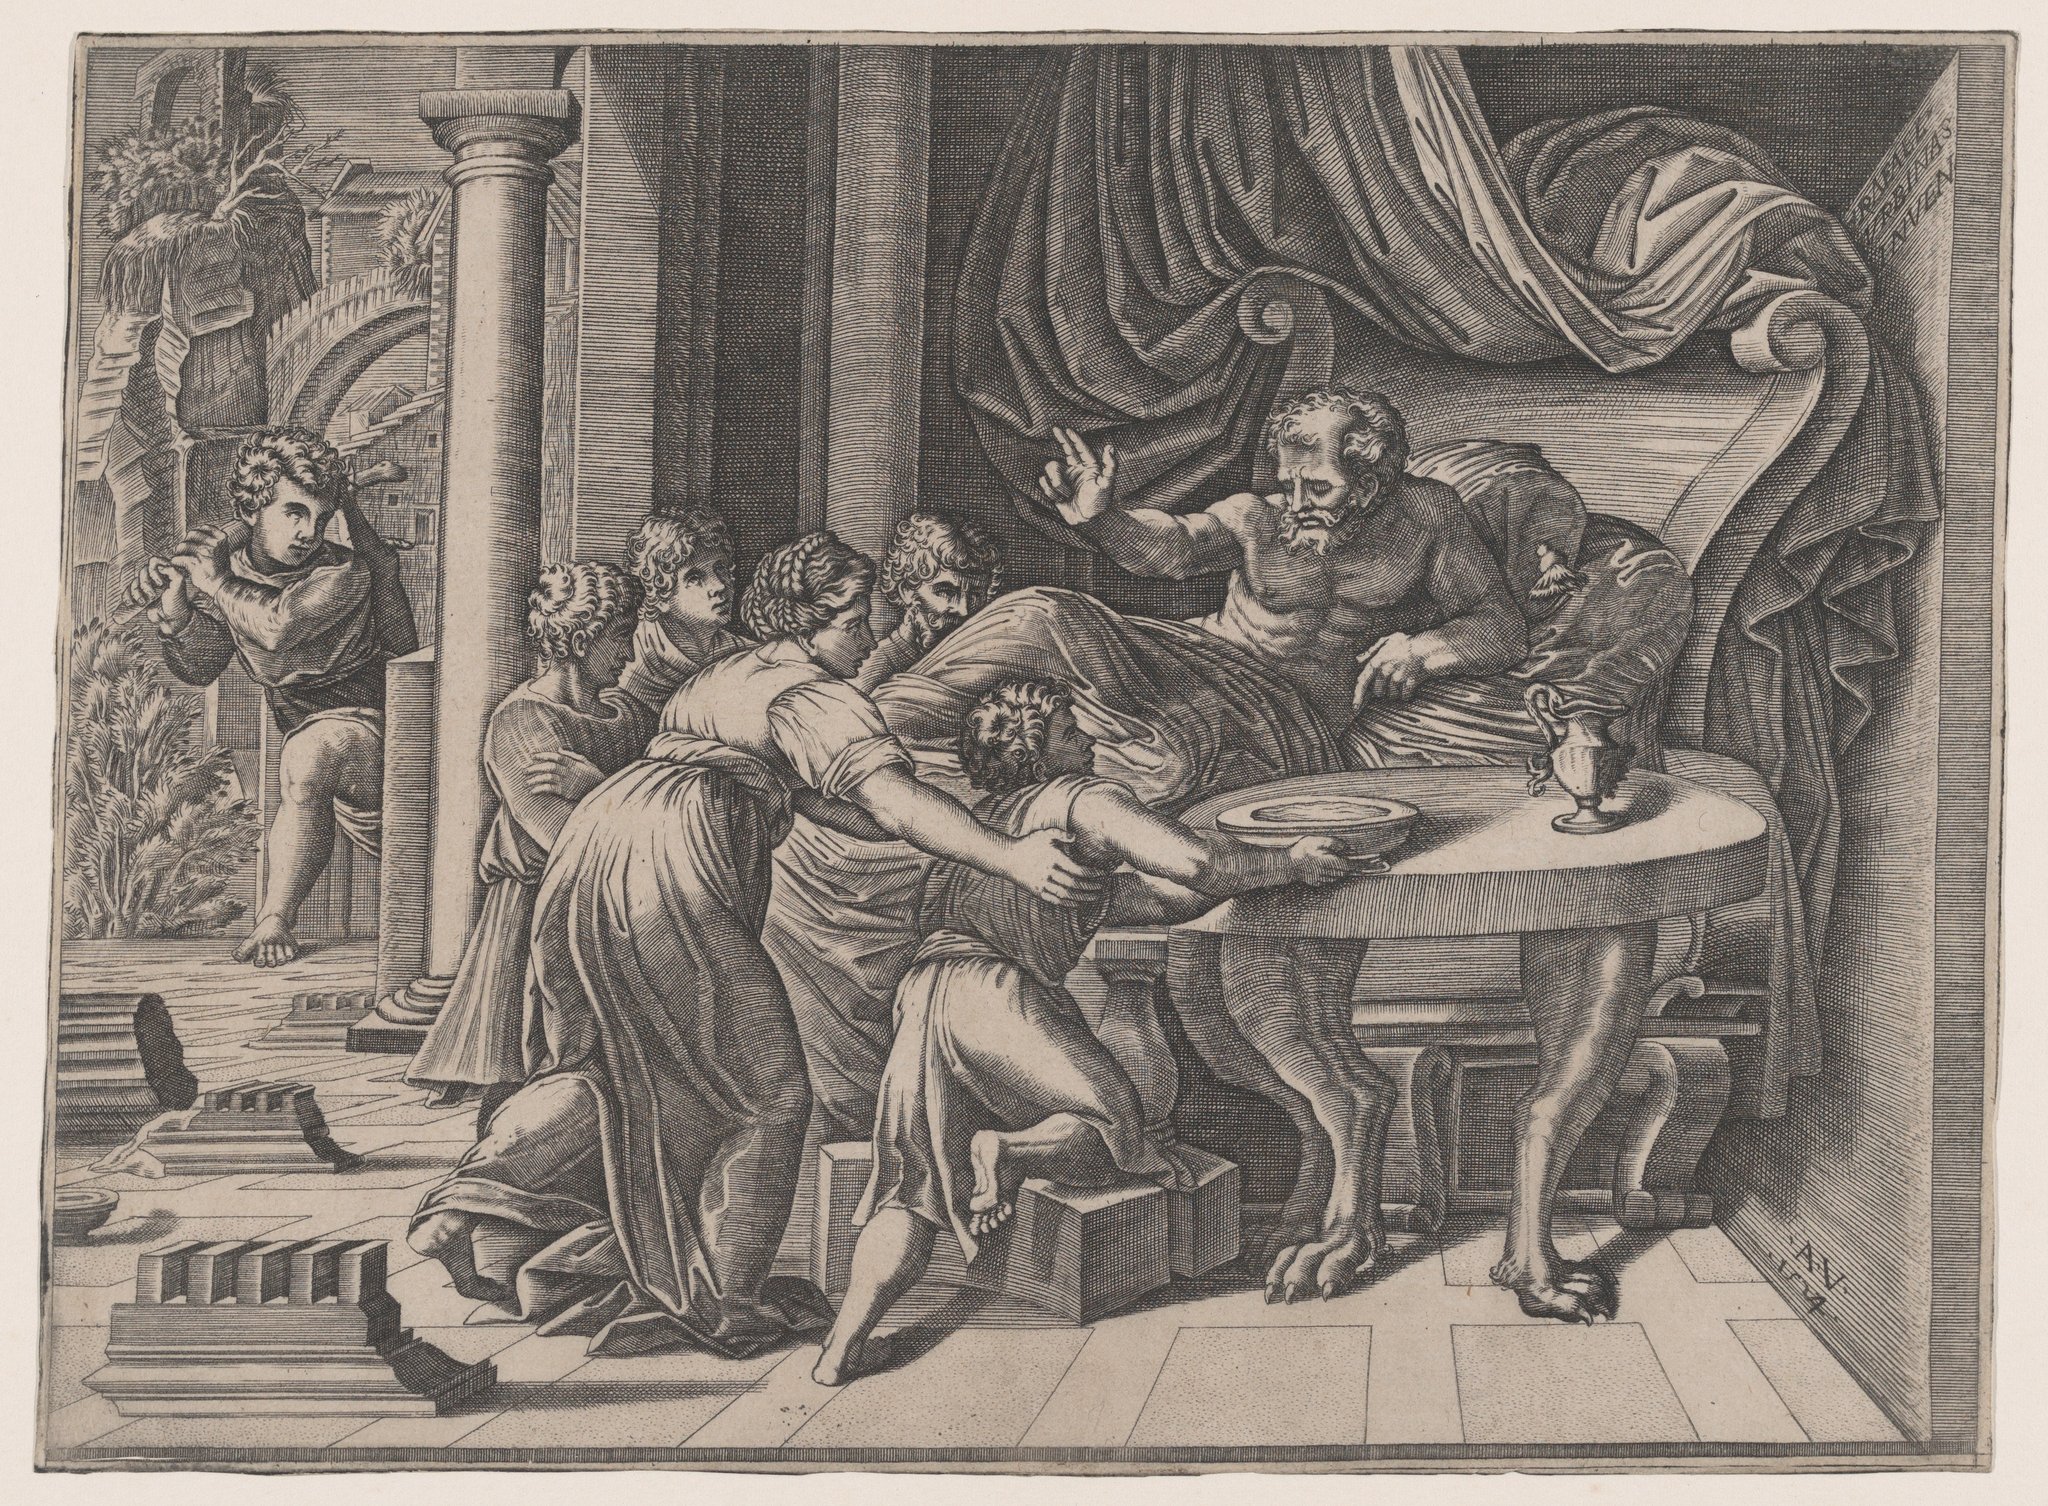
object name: print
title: Isaac Blessing Jacob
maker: agostino veneziano (agostino dei musi)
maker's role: artist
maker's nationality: italian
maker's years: 1490-1536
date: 1524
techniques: engraving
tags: boys,men,women